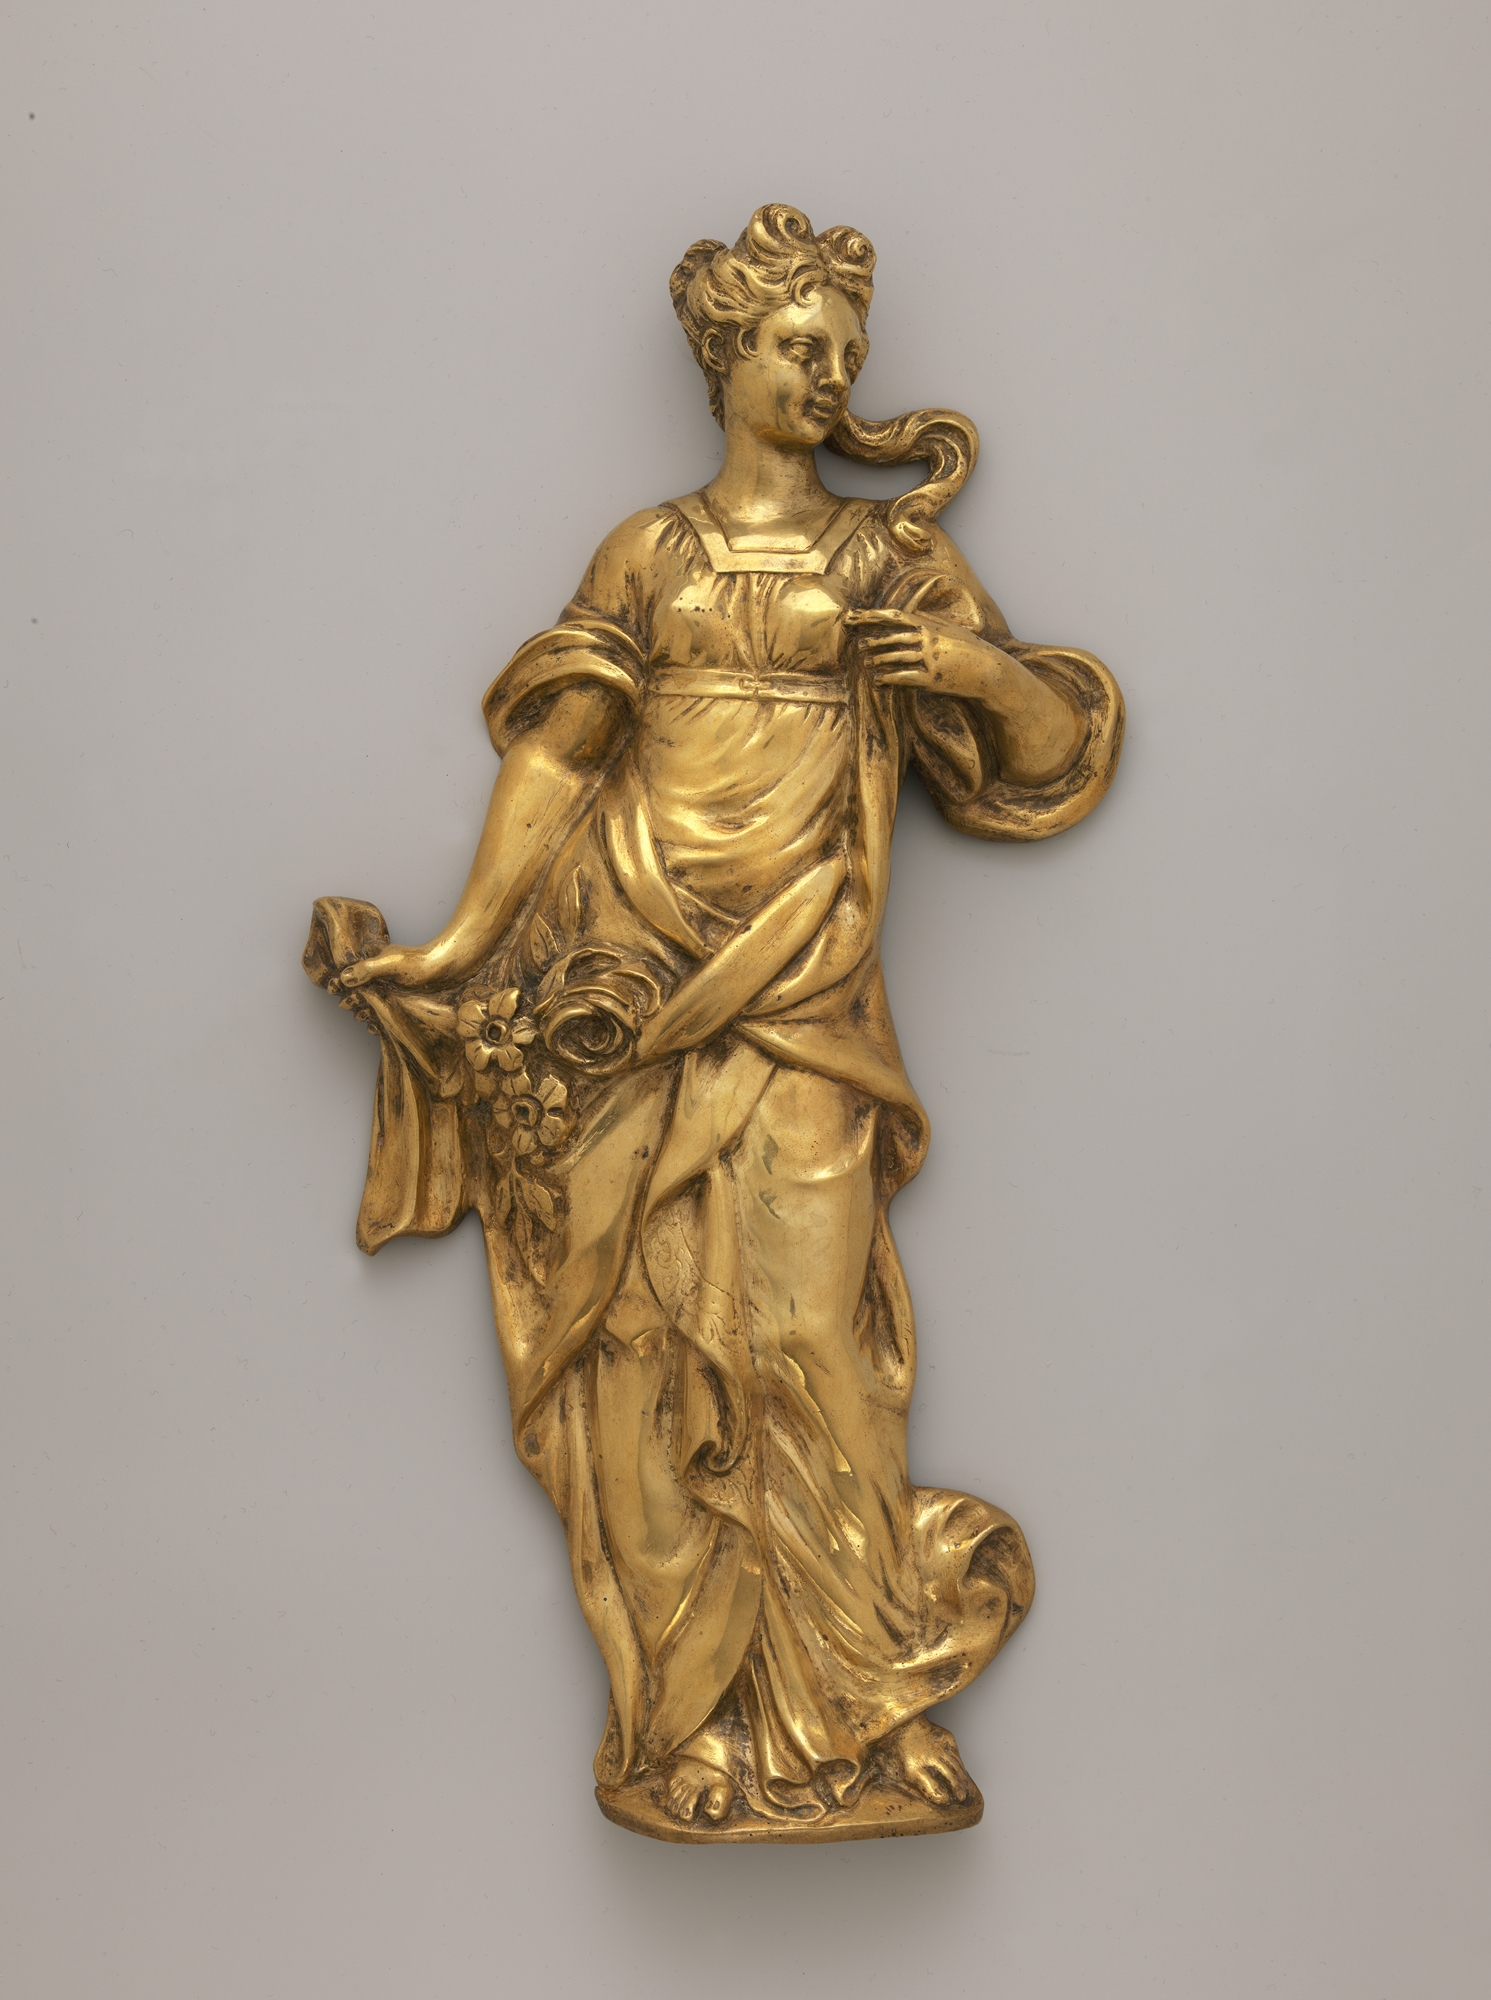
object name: panel ornament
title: Panel ornament (part of a set)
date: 1667-1733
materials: gilt bronze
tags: women,flowers